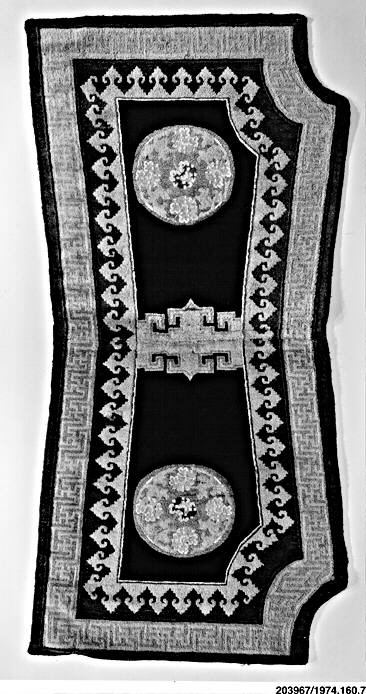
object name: rug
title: Saddle Rug with Peony Roundels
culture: chinese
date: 1701-1800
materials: cotton, wool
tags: peonies